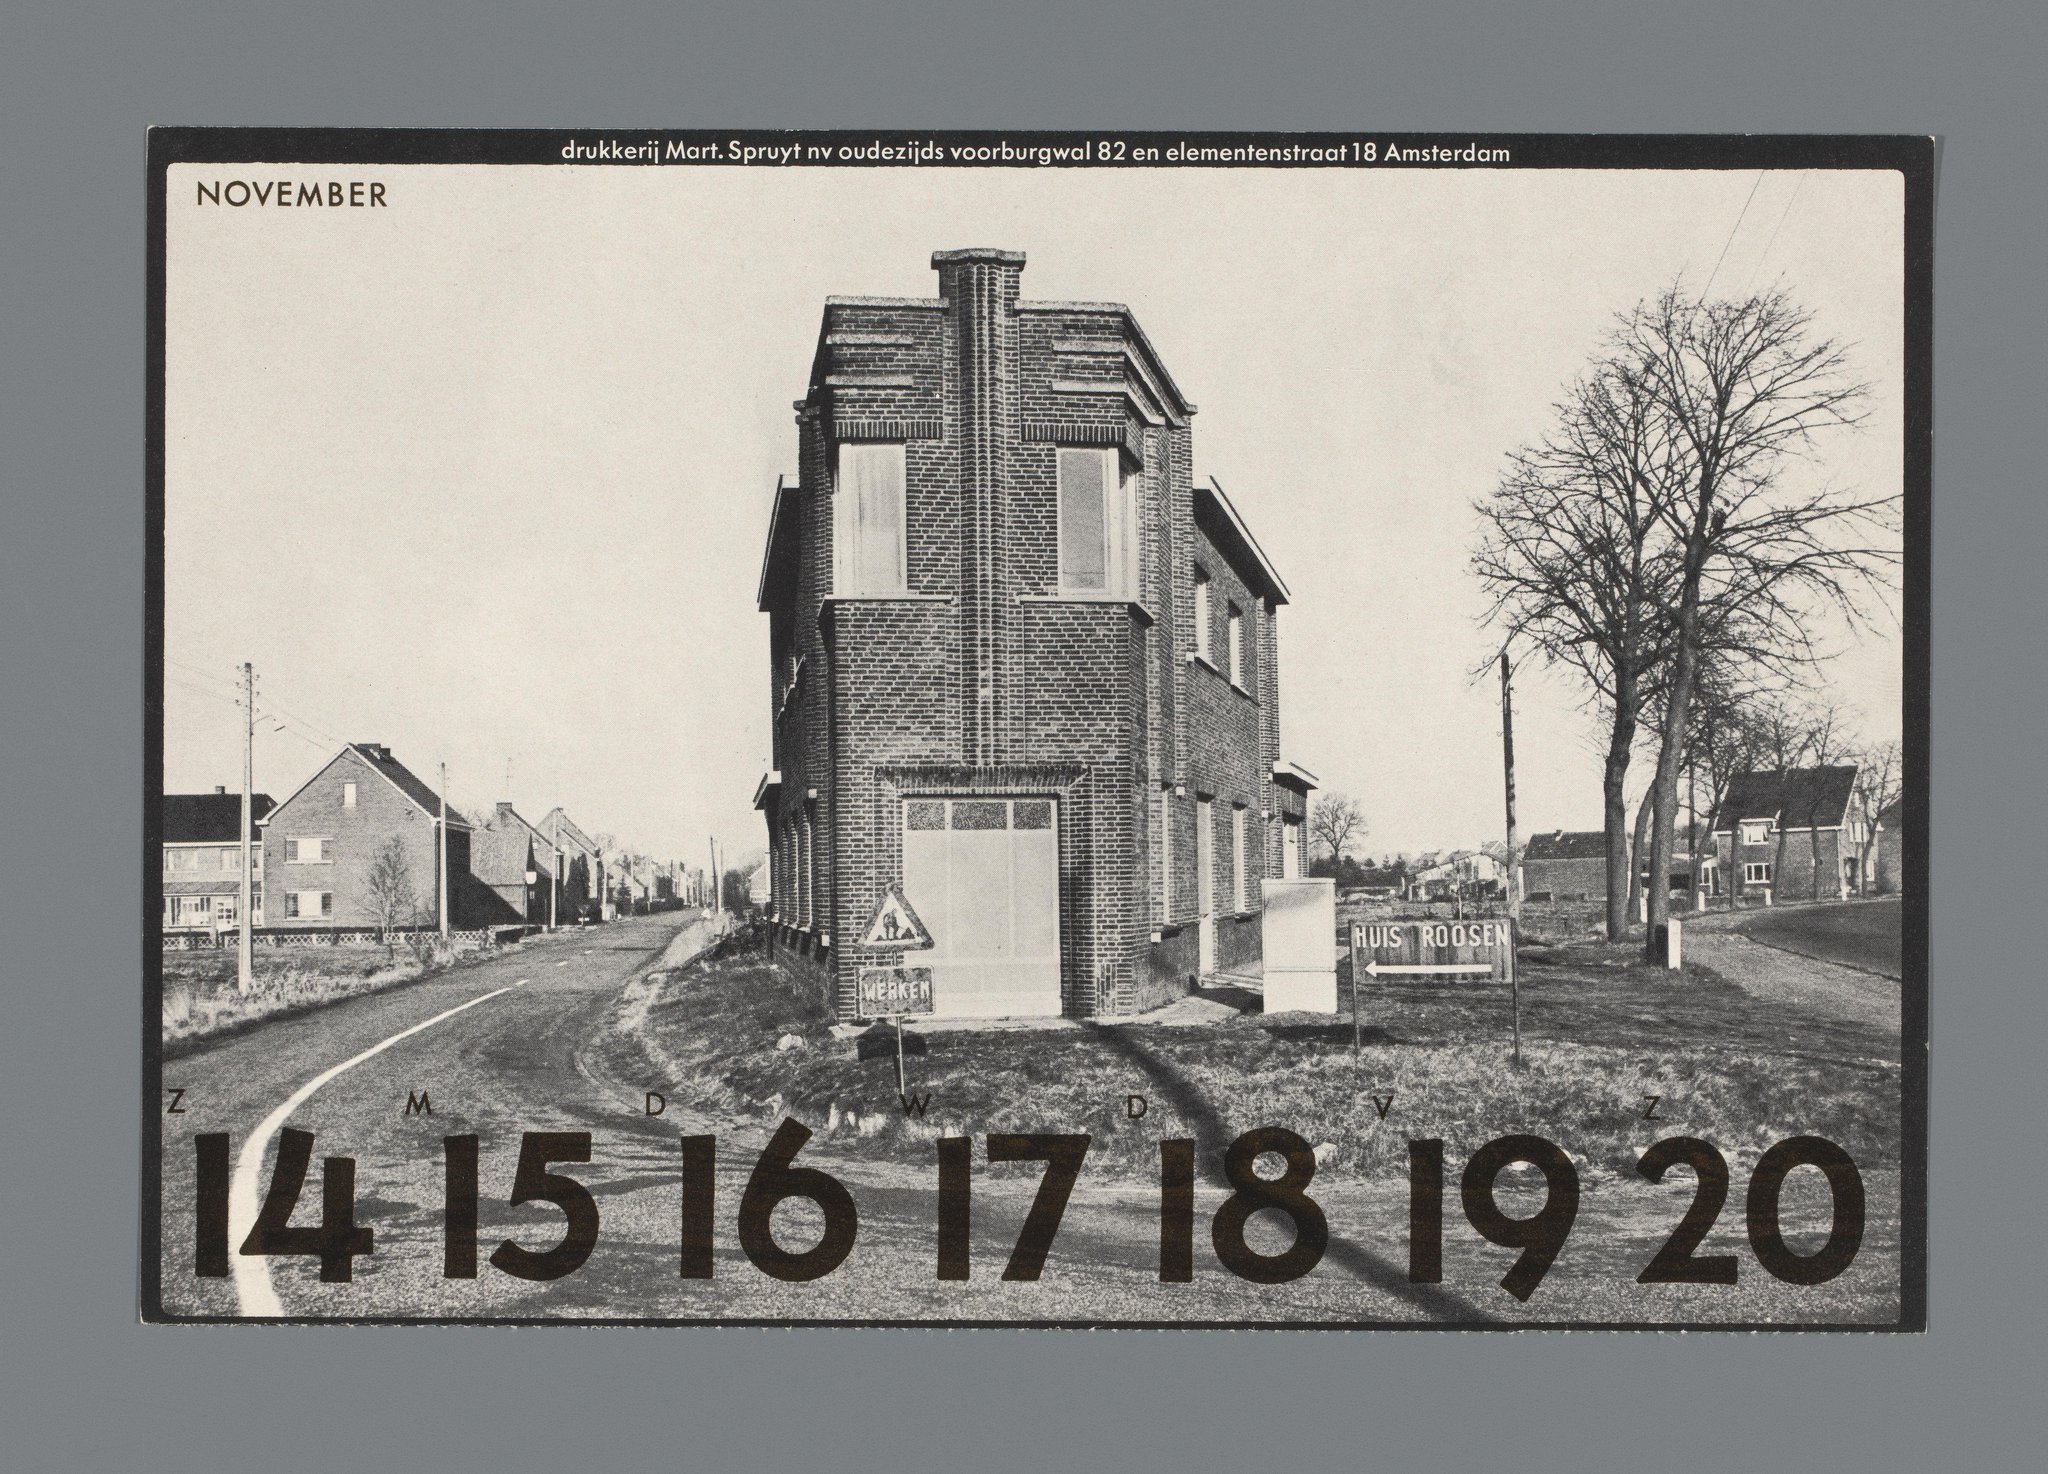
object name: photograph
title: België. Huizen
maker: Anonymous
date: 1900-1950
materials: paper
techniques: offset printed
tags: belgium